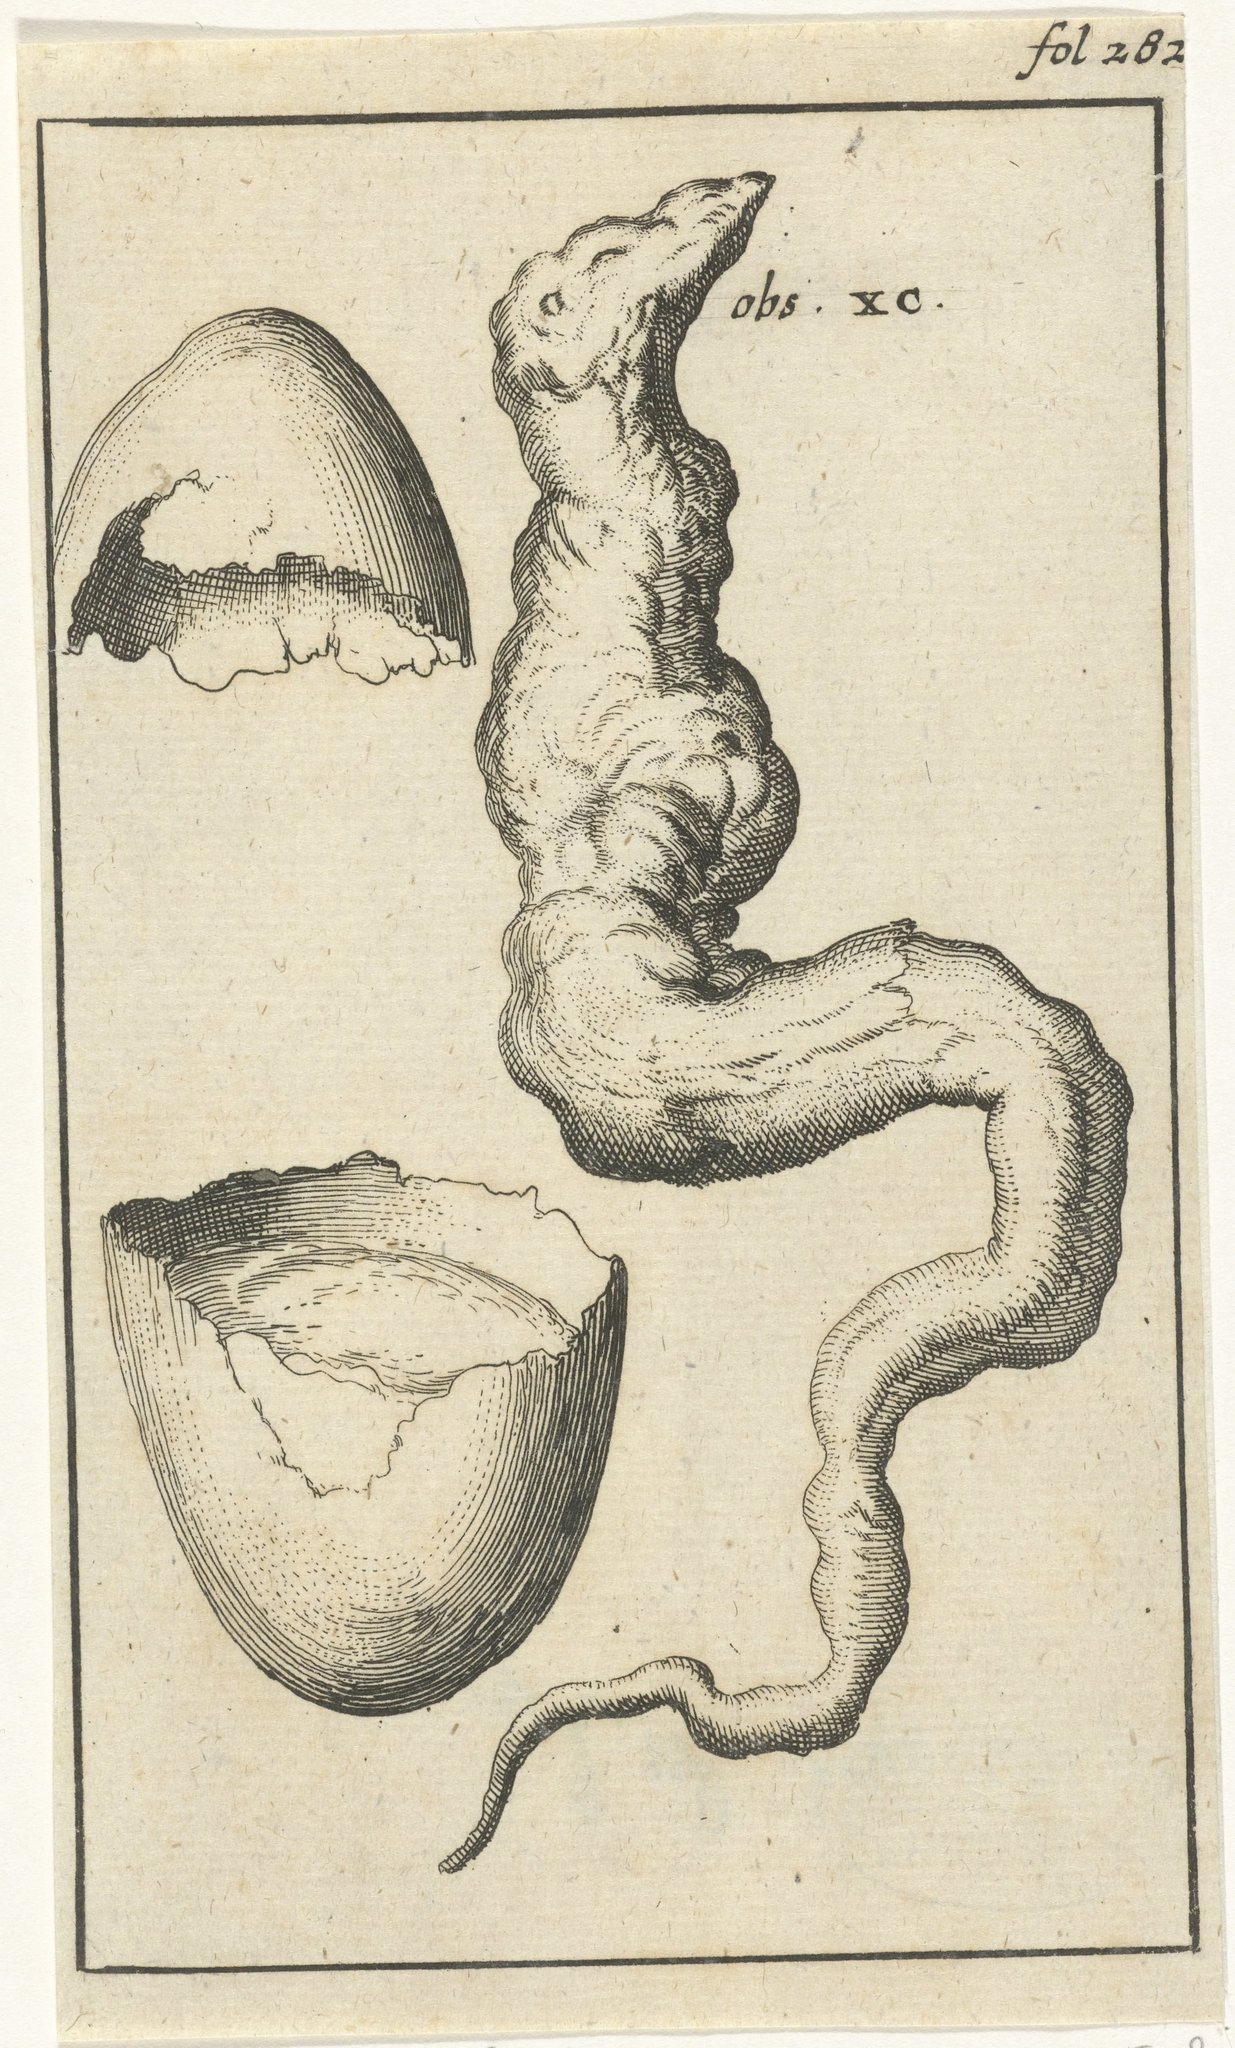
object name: book illustration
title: Anatomische afbeelding IX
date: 1680-1688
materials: paper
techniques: etching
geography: amsterdam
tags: biology, anatomical models (usually series of five figures)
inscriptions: collector's mark: Lugt 2228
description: Illustratie opgenomen in: Blankaart, Steven. Collectanea medico-physica, oft Hollands jaar-register der genees- en natuur-kundige aanmerkingen, 3 delen, dl. I, fol. 282. Amsterdam: Jan Claesz ten Hoorn, 1680-1688.